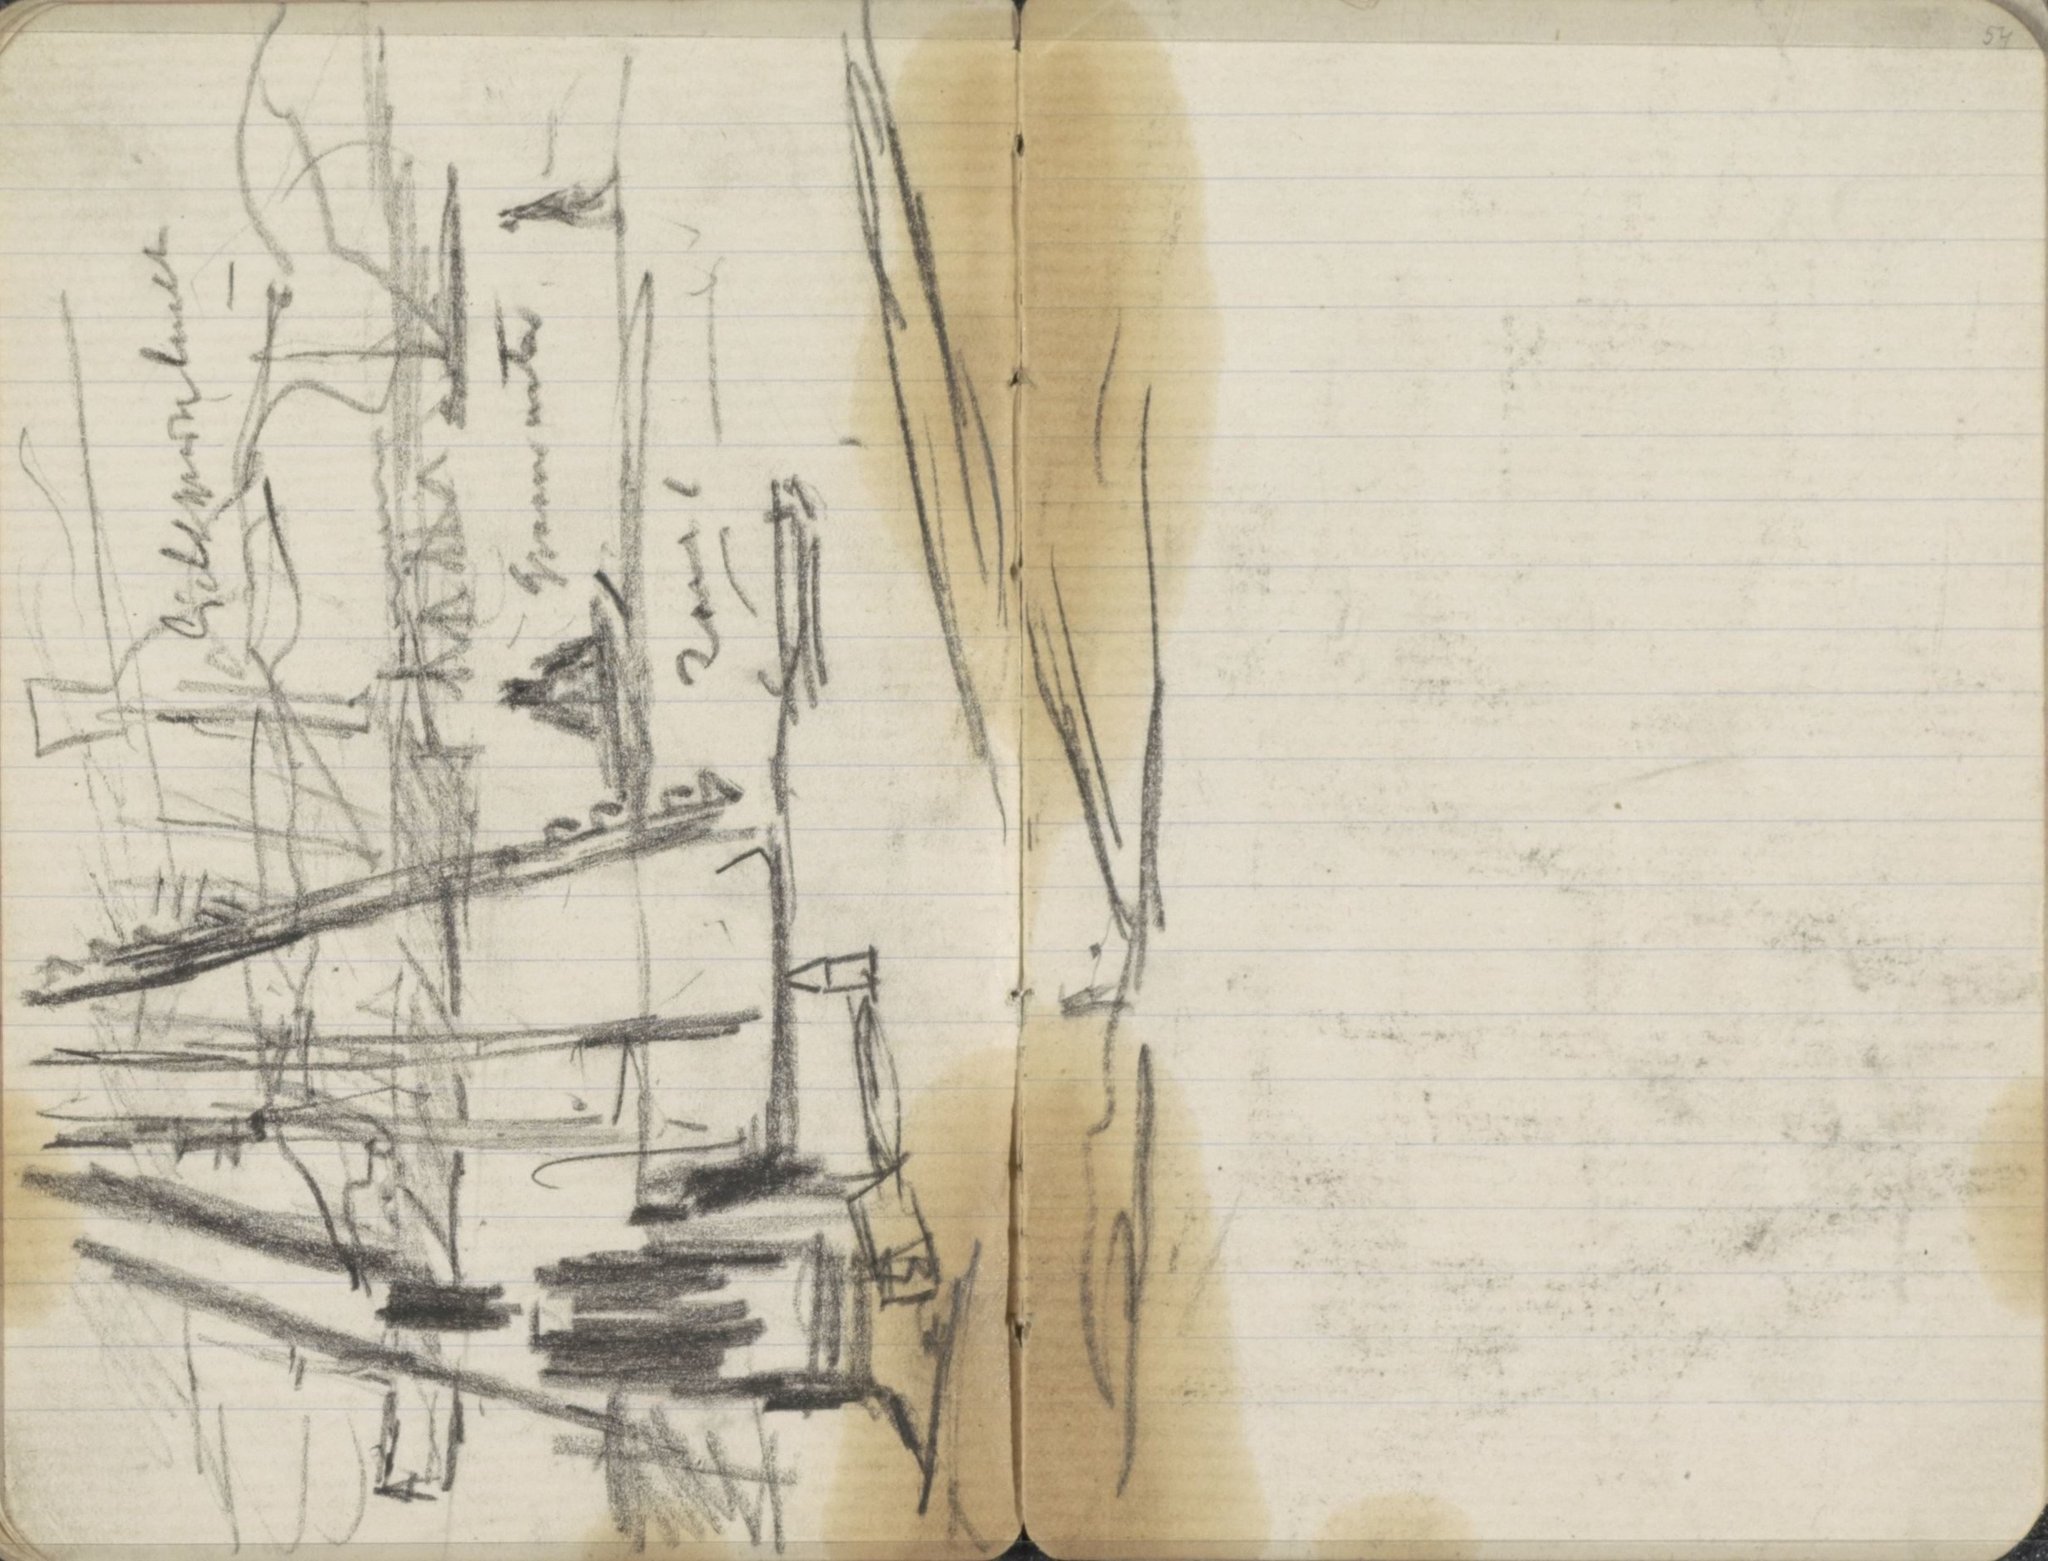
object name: sketchbook leaf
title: Gezicht op de Barentszkade te Amsterdam met heimaterieel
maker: george hendrik breitner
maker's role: draughtsman, painter, print maker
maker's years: 1857-1923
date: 1896-1901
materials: chalk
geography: amsterdam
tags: ramming, driving piles (~ building activities), pier, quay, wharf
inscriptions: kleurnotitie, handgeschreven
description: Pagina 53 en pagina 54 uit een schetsboek met 37 bladen.